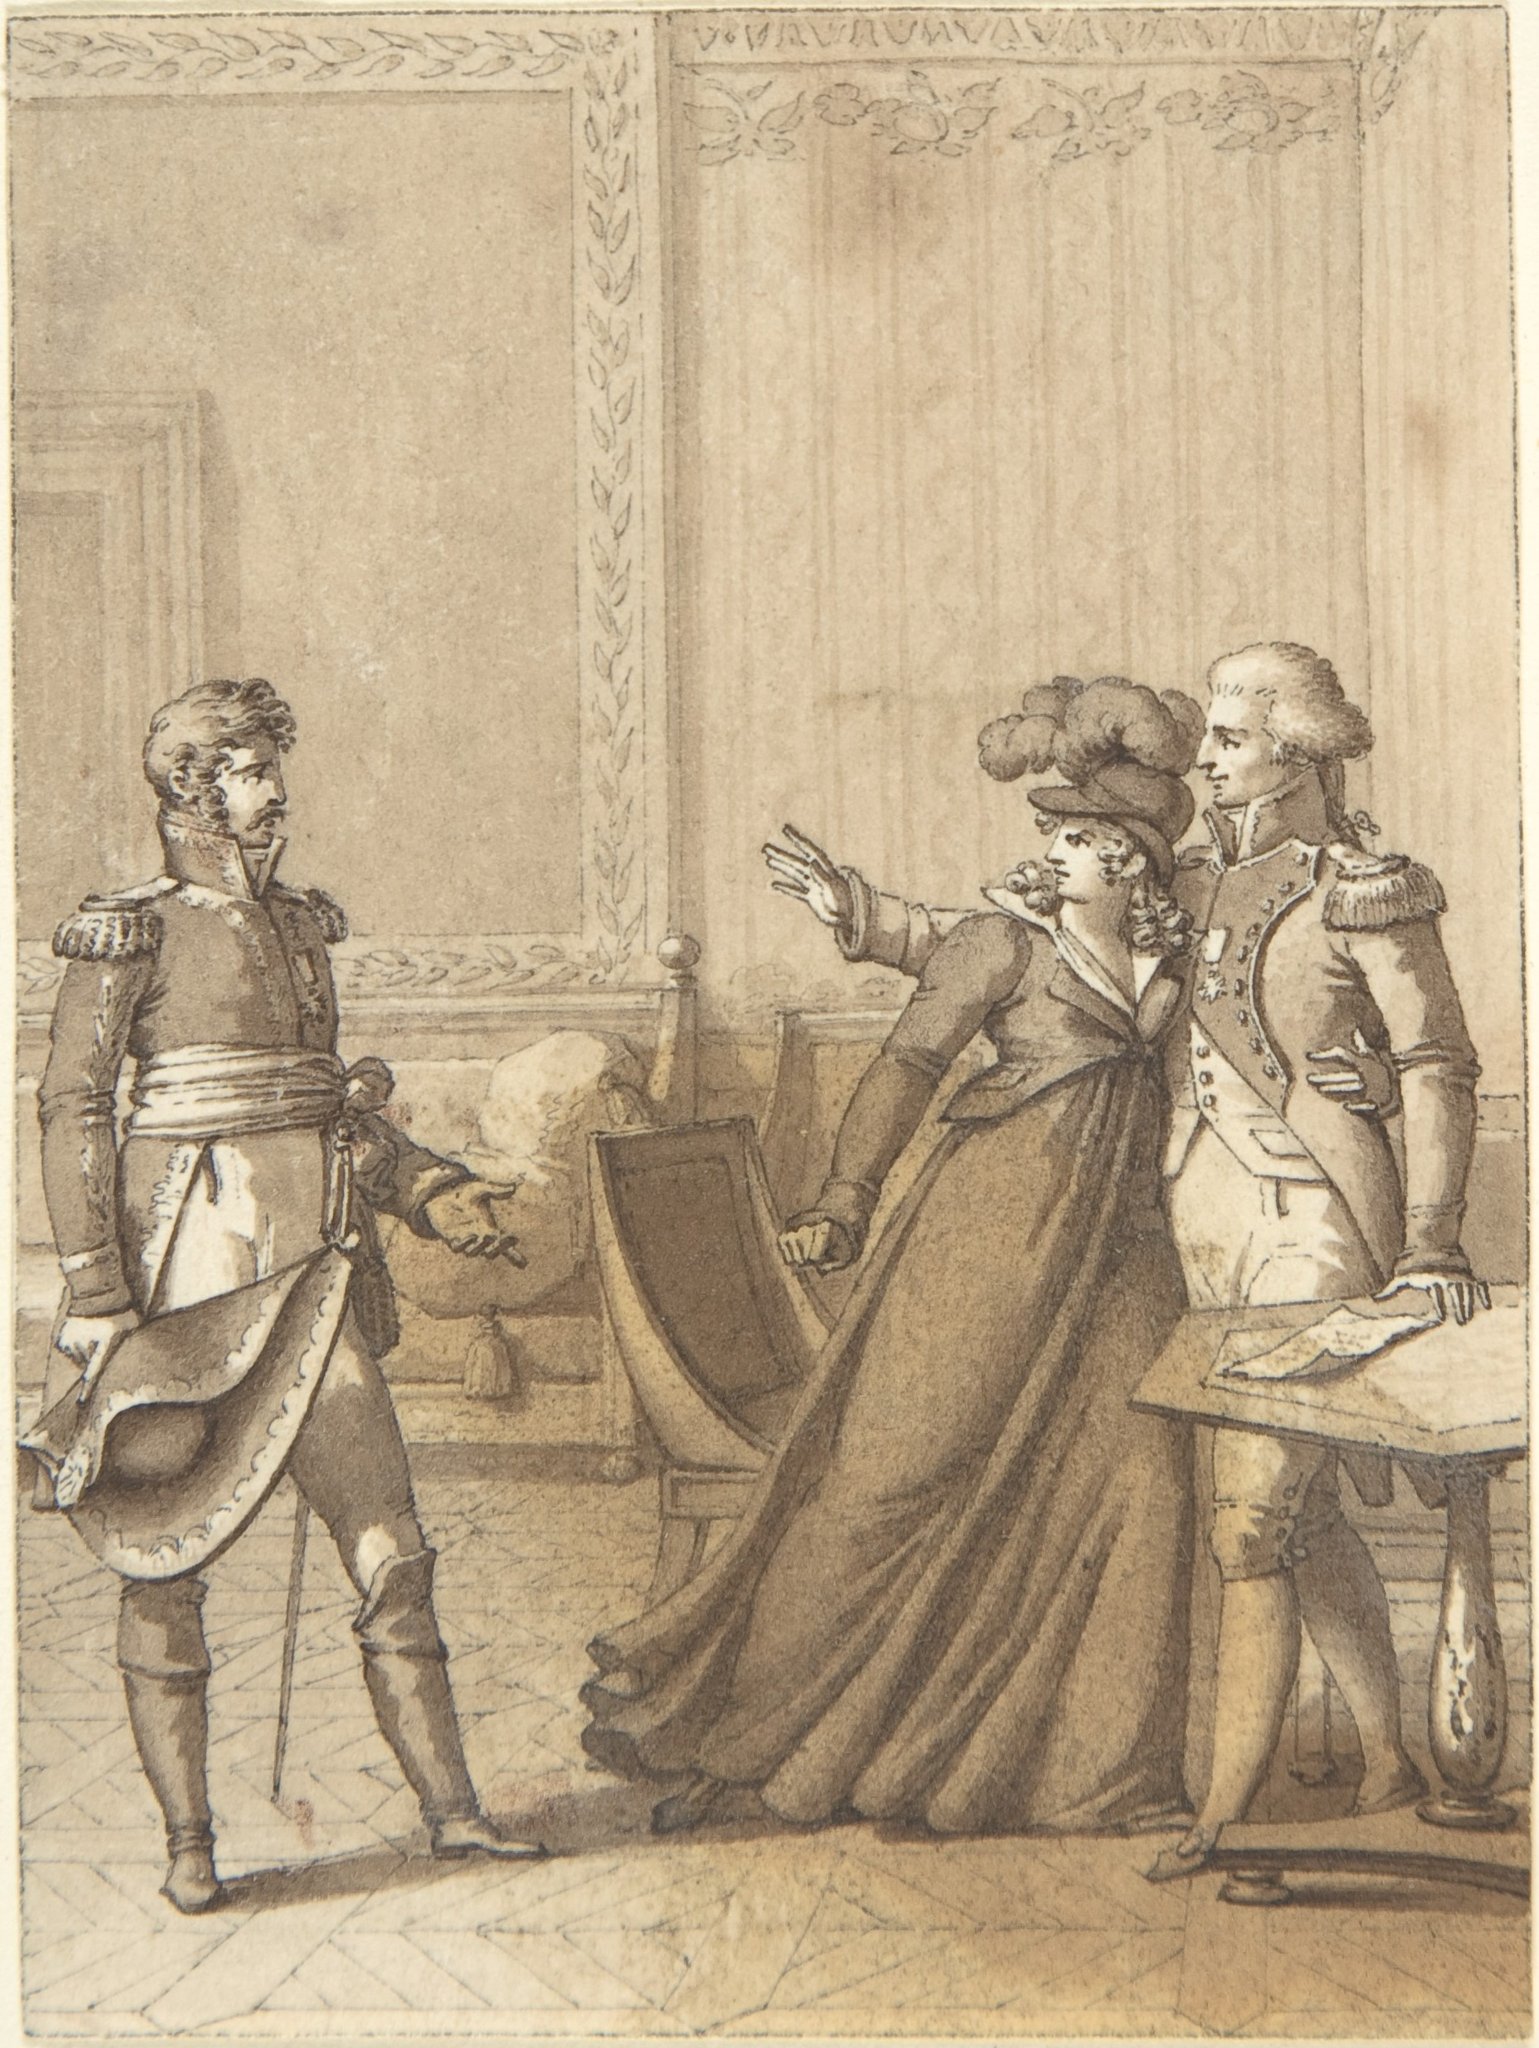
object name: drawing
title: Design for a Book Illustration: a Soldier Approaching a Couple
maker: anonymous, german, 19th century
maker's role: artist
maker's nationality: german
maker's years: 1800-1899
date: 1801-1900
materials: ink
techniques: brush, pen, wash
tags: soldiers,couples,men,women